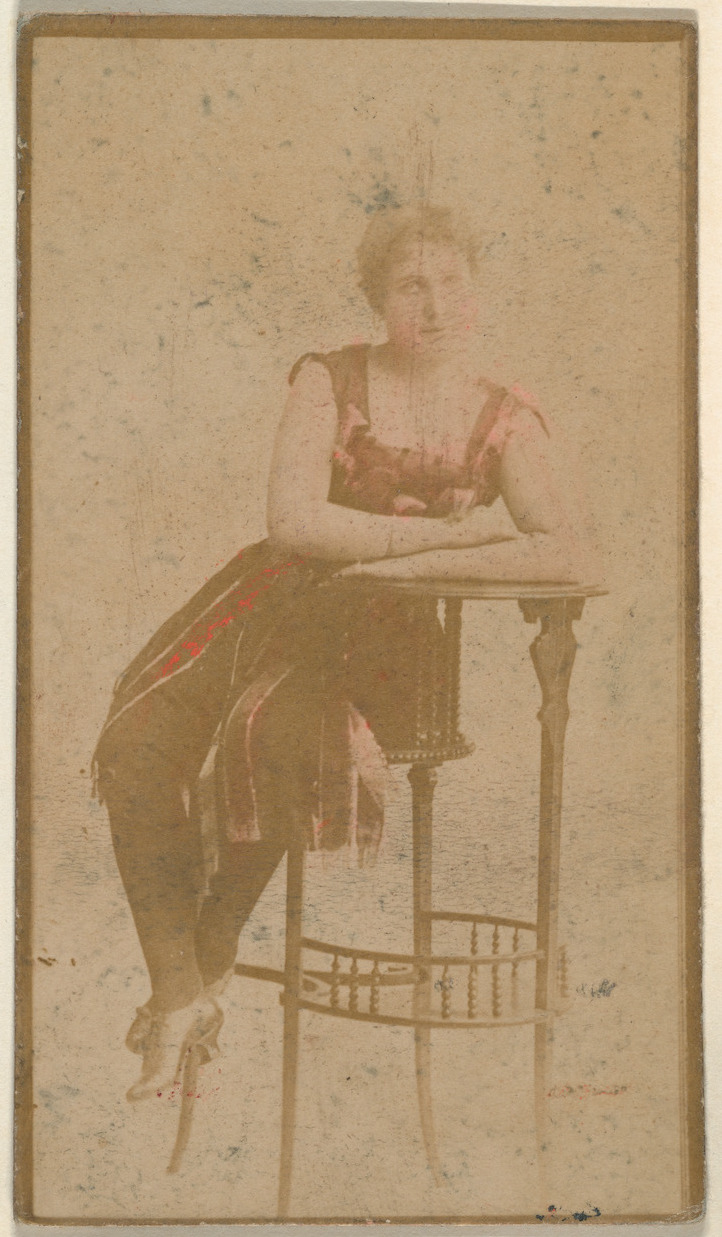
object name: photograph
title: Seated actress leaning on table, from the Actresses series (N668)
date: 1888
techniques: albumen silver print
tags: portraits,women,actresses